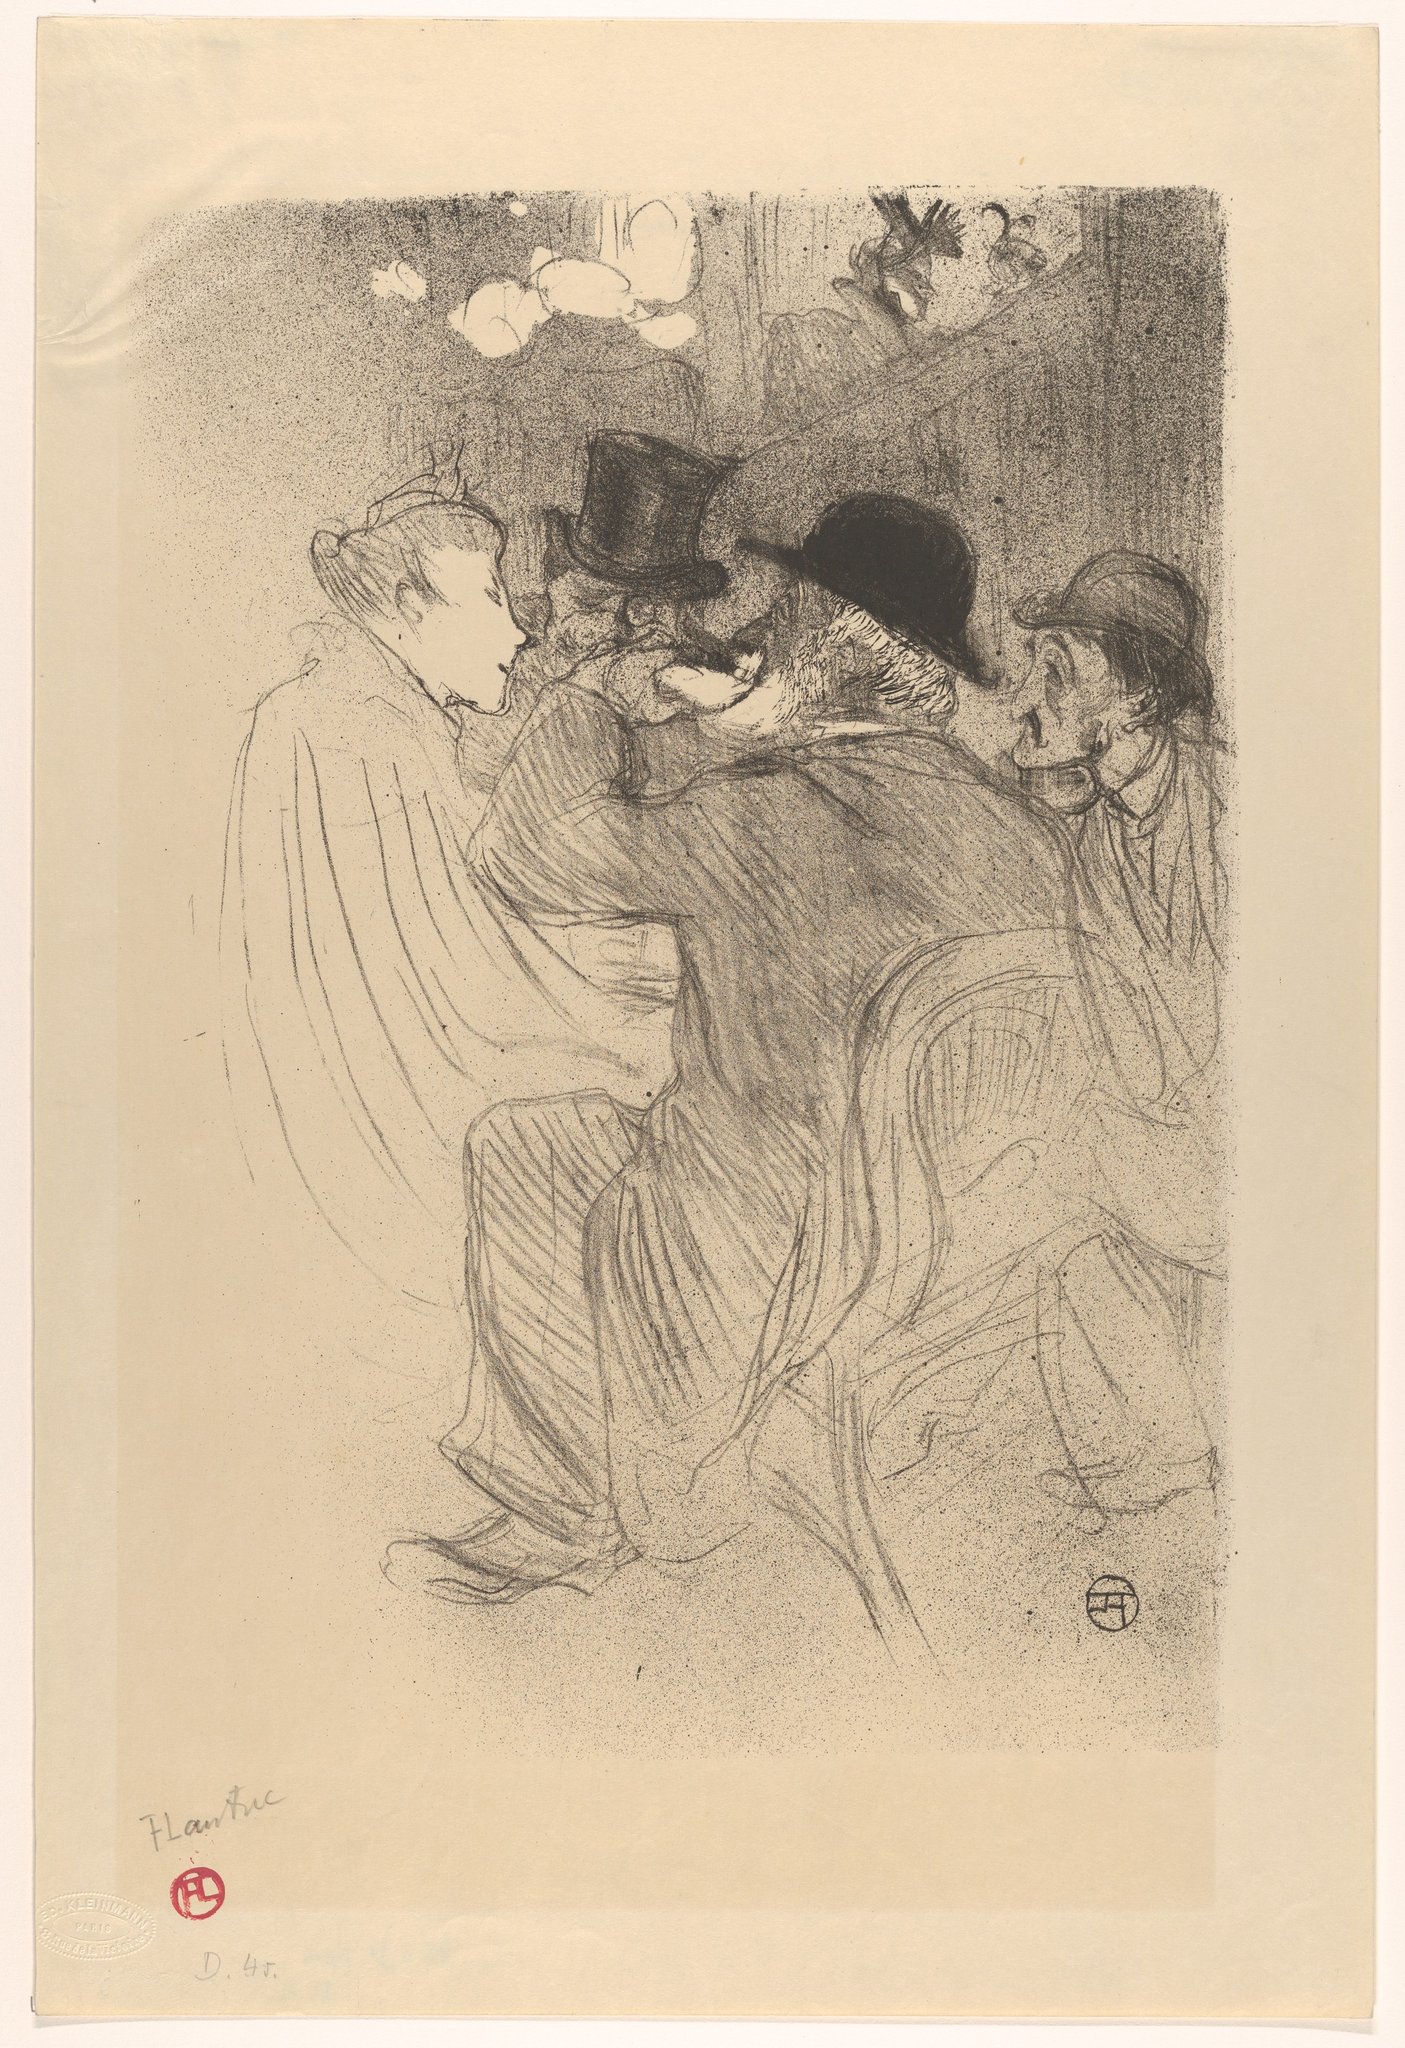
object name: print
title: Au Moulin Rouge: Un Rude! Un Vrai Rude!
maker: henri de toulouse-lautrec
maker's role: artist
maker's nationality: french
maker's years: 1864-1901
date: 1893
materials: crayon, paper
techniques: brush, lithograph, printing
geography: france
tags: men